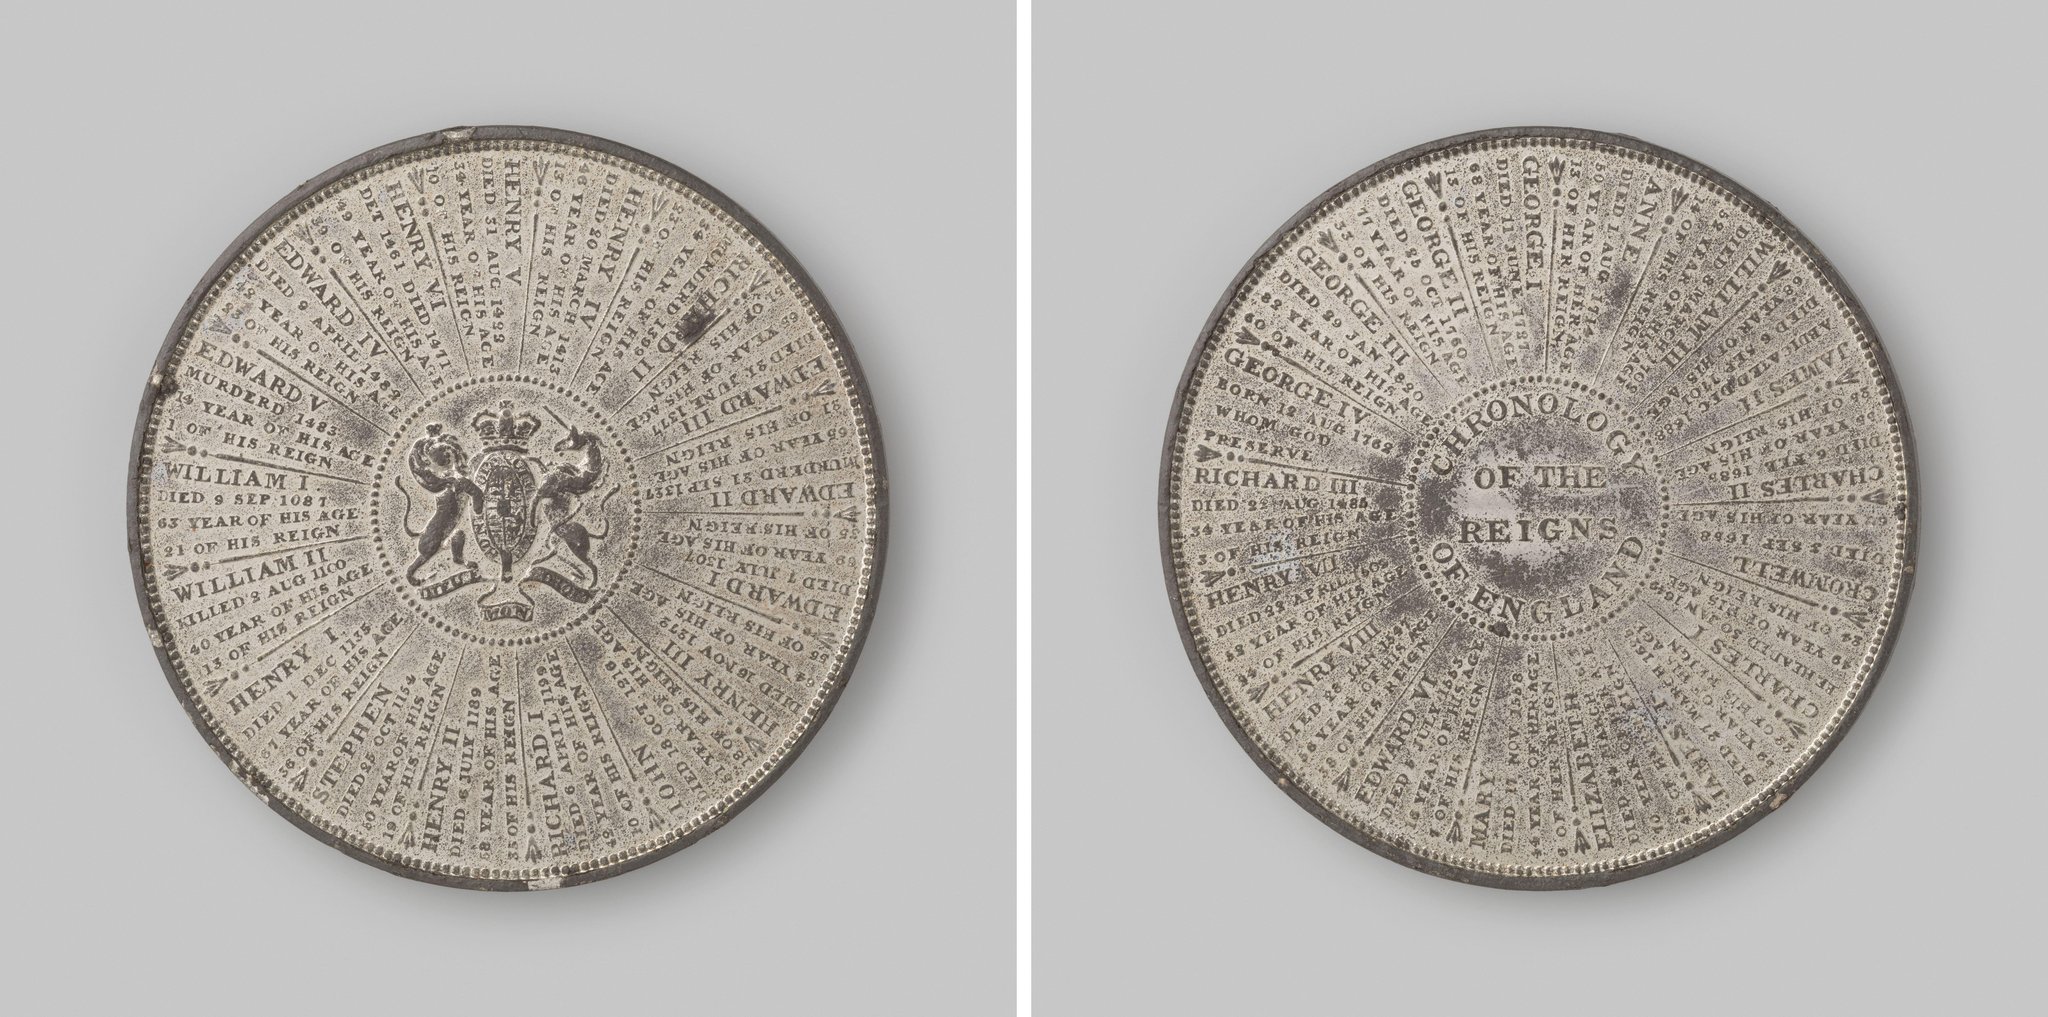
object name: history medal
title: Chronologie van de Engelse vorsten (ca 1825)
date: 1820-1830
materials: tin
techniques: striking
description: Tinnen penning, op de voorzijde het gekroonde Britse wapen met dragers in een cirkel, de ruimte daarbuiten verdeeld in segmenten met daarin geschreven de naam, sterfdatum en regeringsduur van de Engelse koningen, op de keerzijde vier regels tekst in een cirkel, de ruimte daarbuiten verdeeld als op de voorzijde.